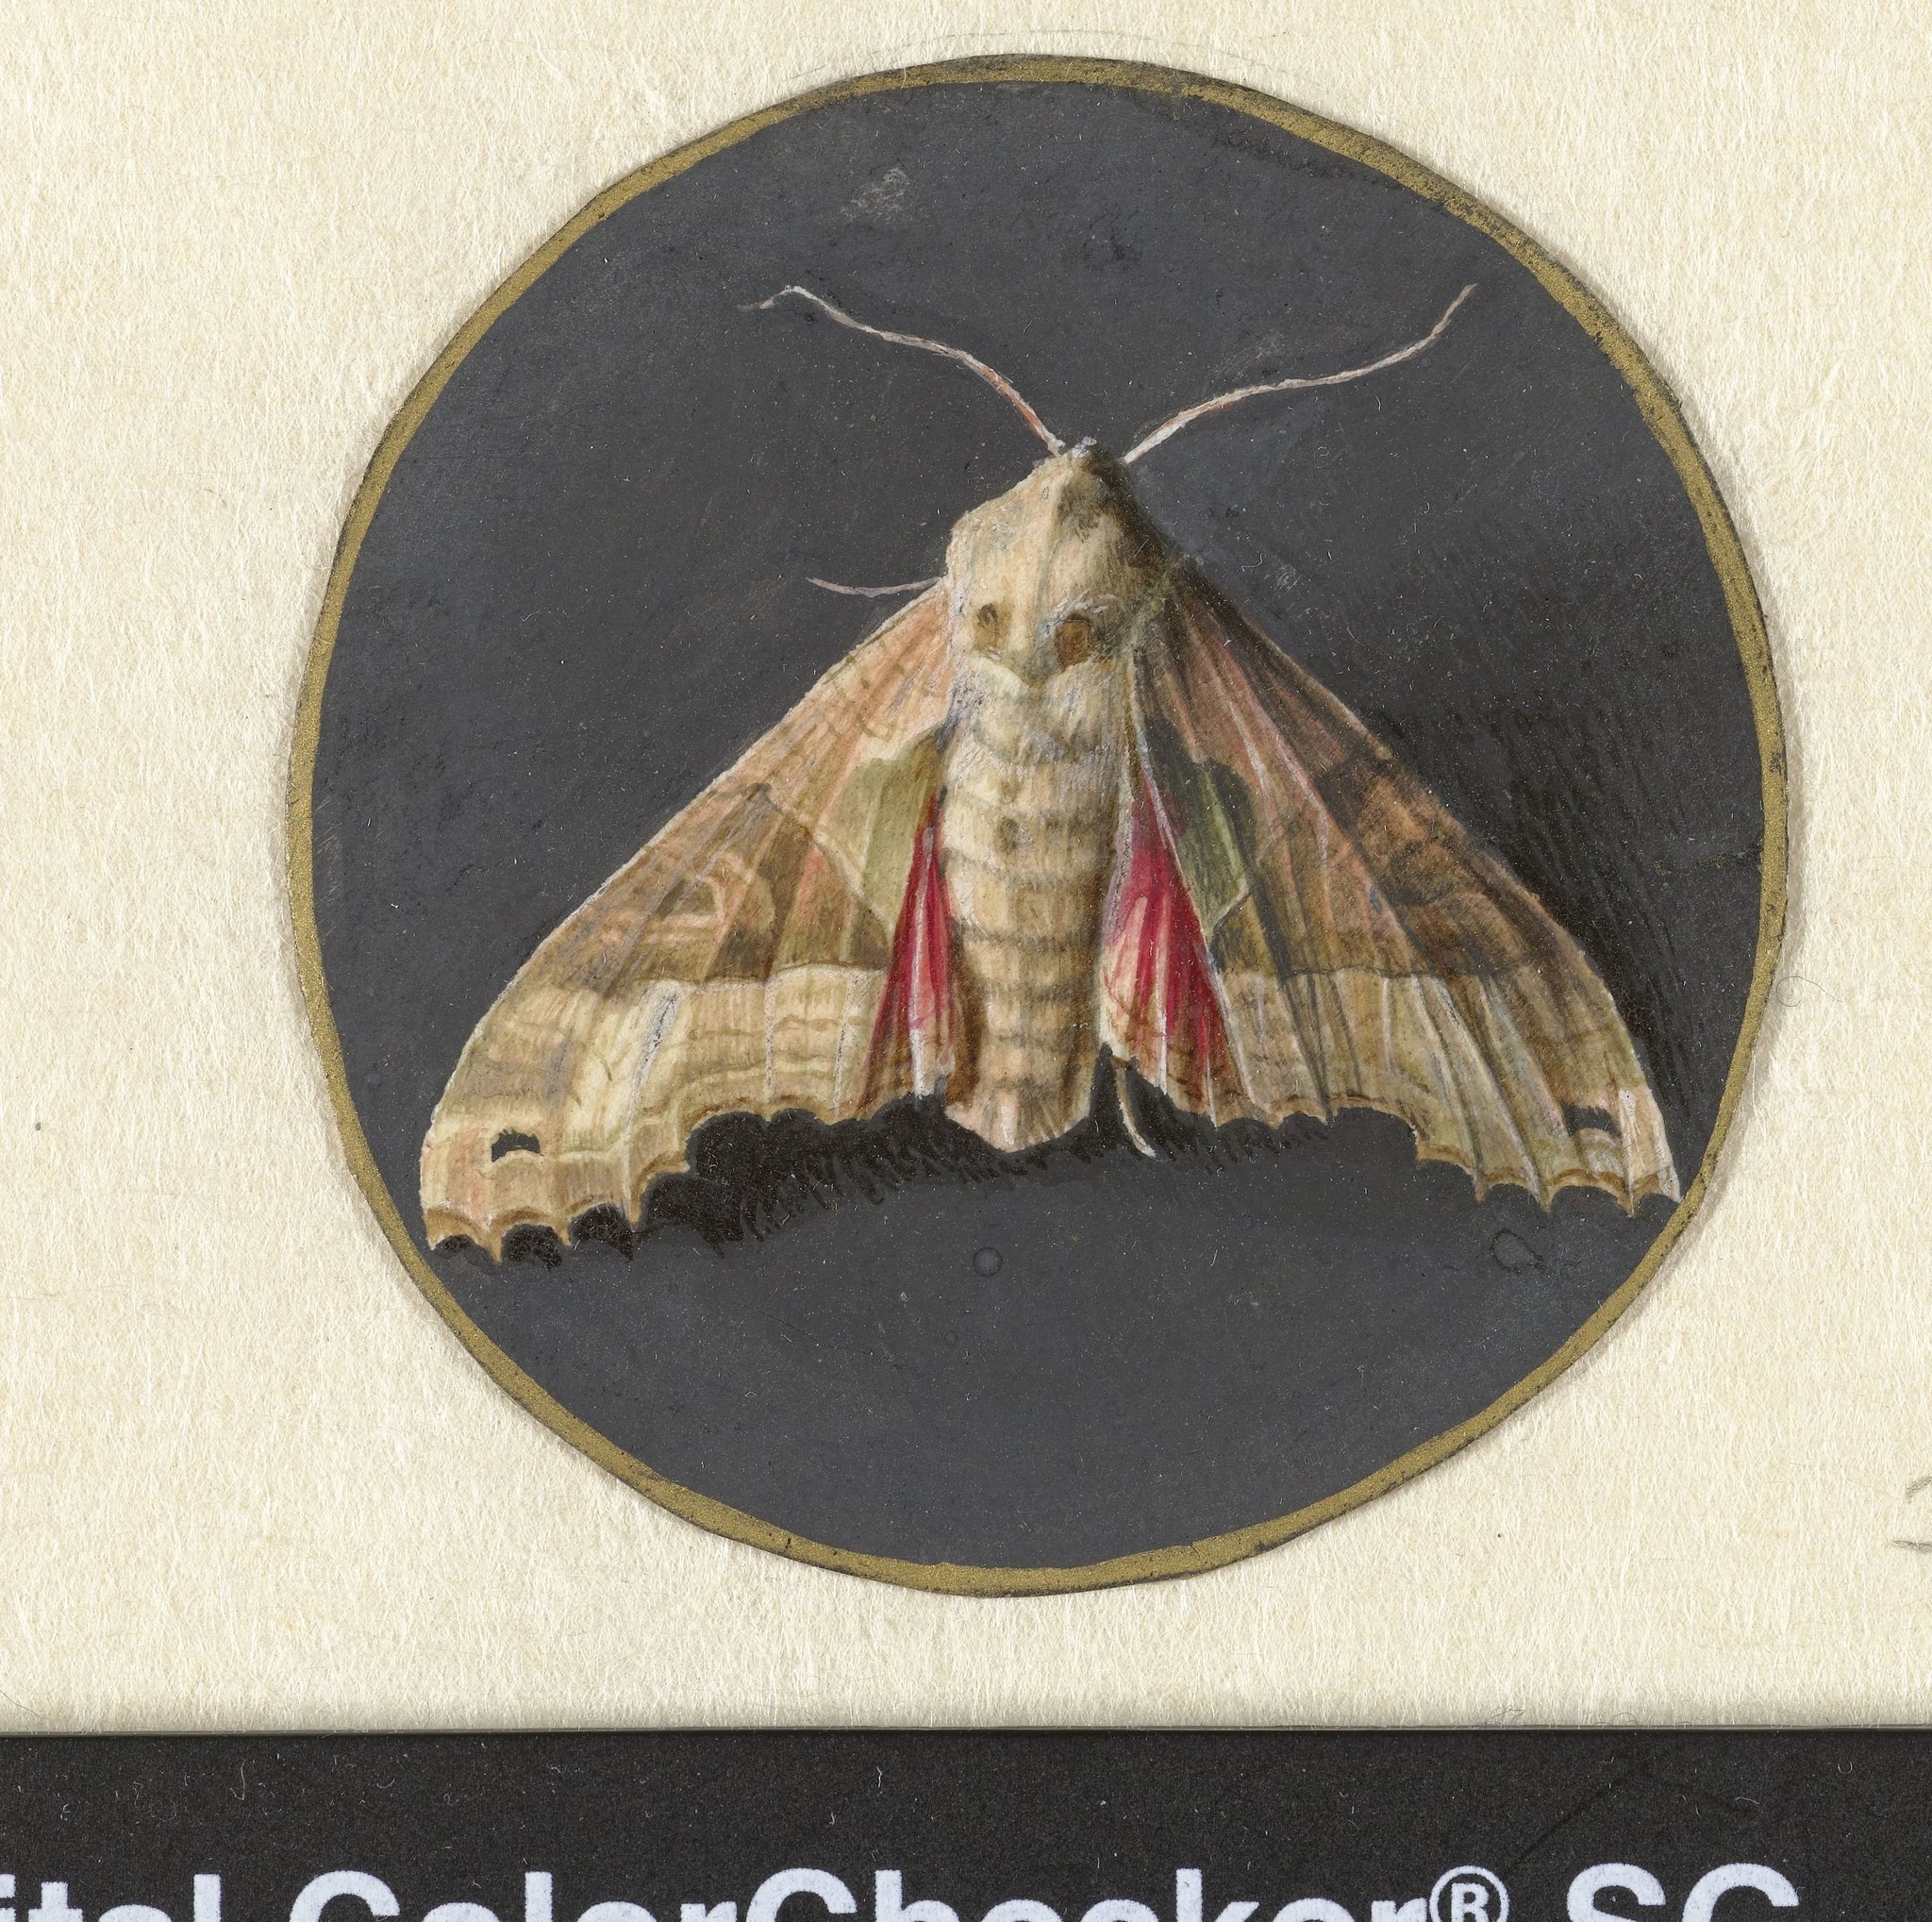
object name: drawing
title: Dieren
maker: jan augustin van der goes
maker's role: draughtsman, painter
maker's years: 1671-1697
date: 1690-1700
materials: paint, gouache, parchment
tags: insects: moth